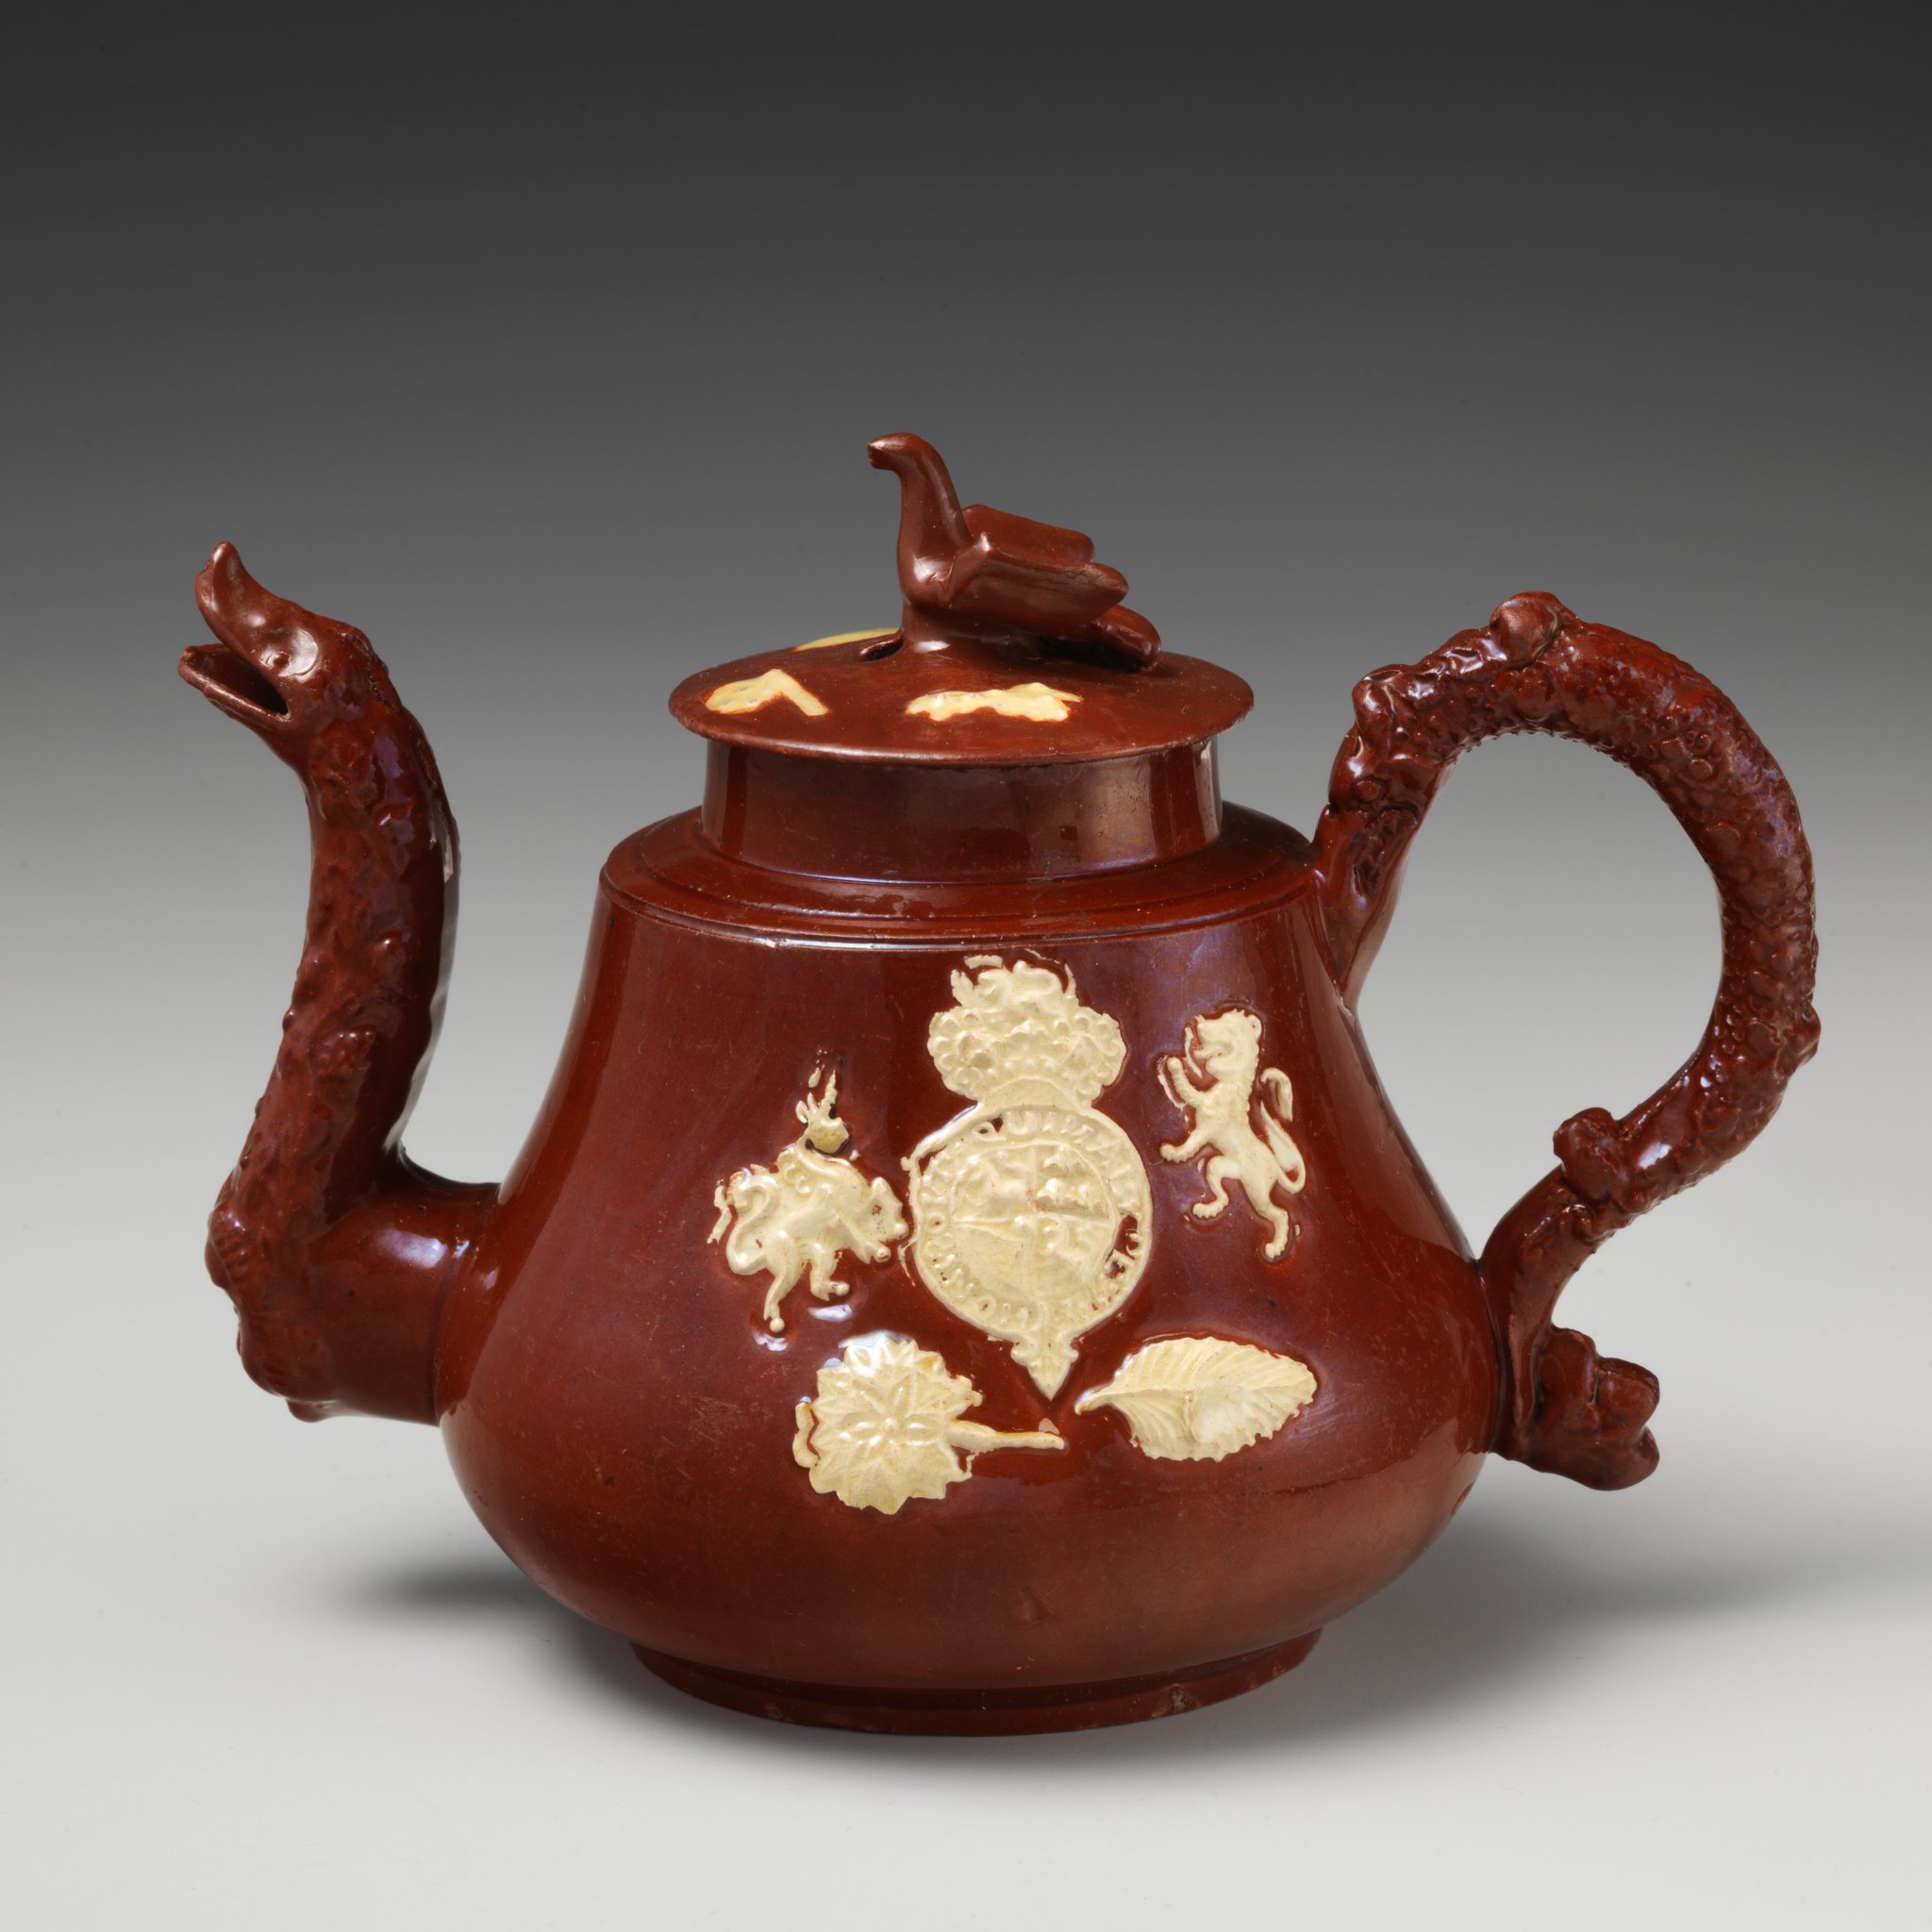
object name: teapot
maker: john astbury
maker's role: maker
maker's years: 1688-1743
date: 1745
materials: earthenware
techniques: glazing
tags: birds,lions,coat of arms